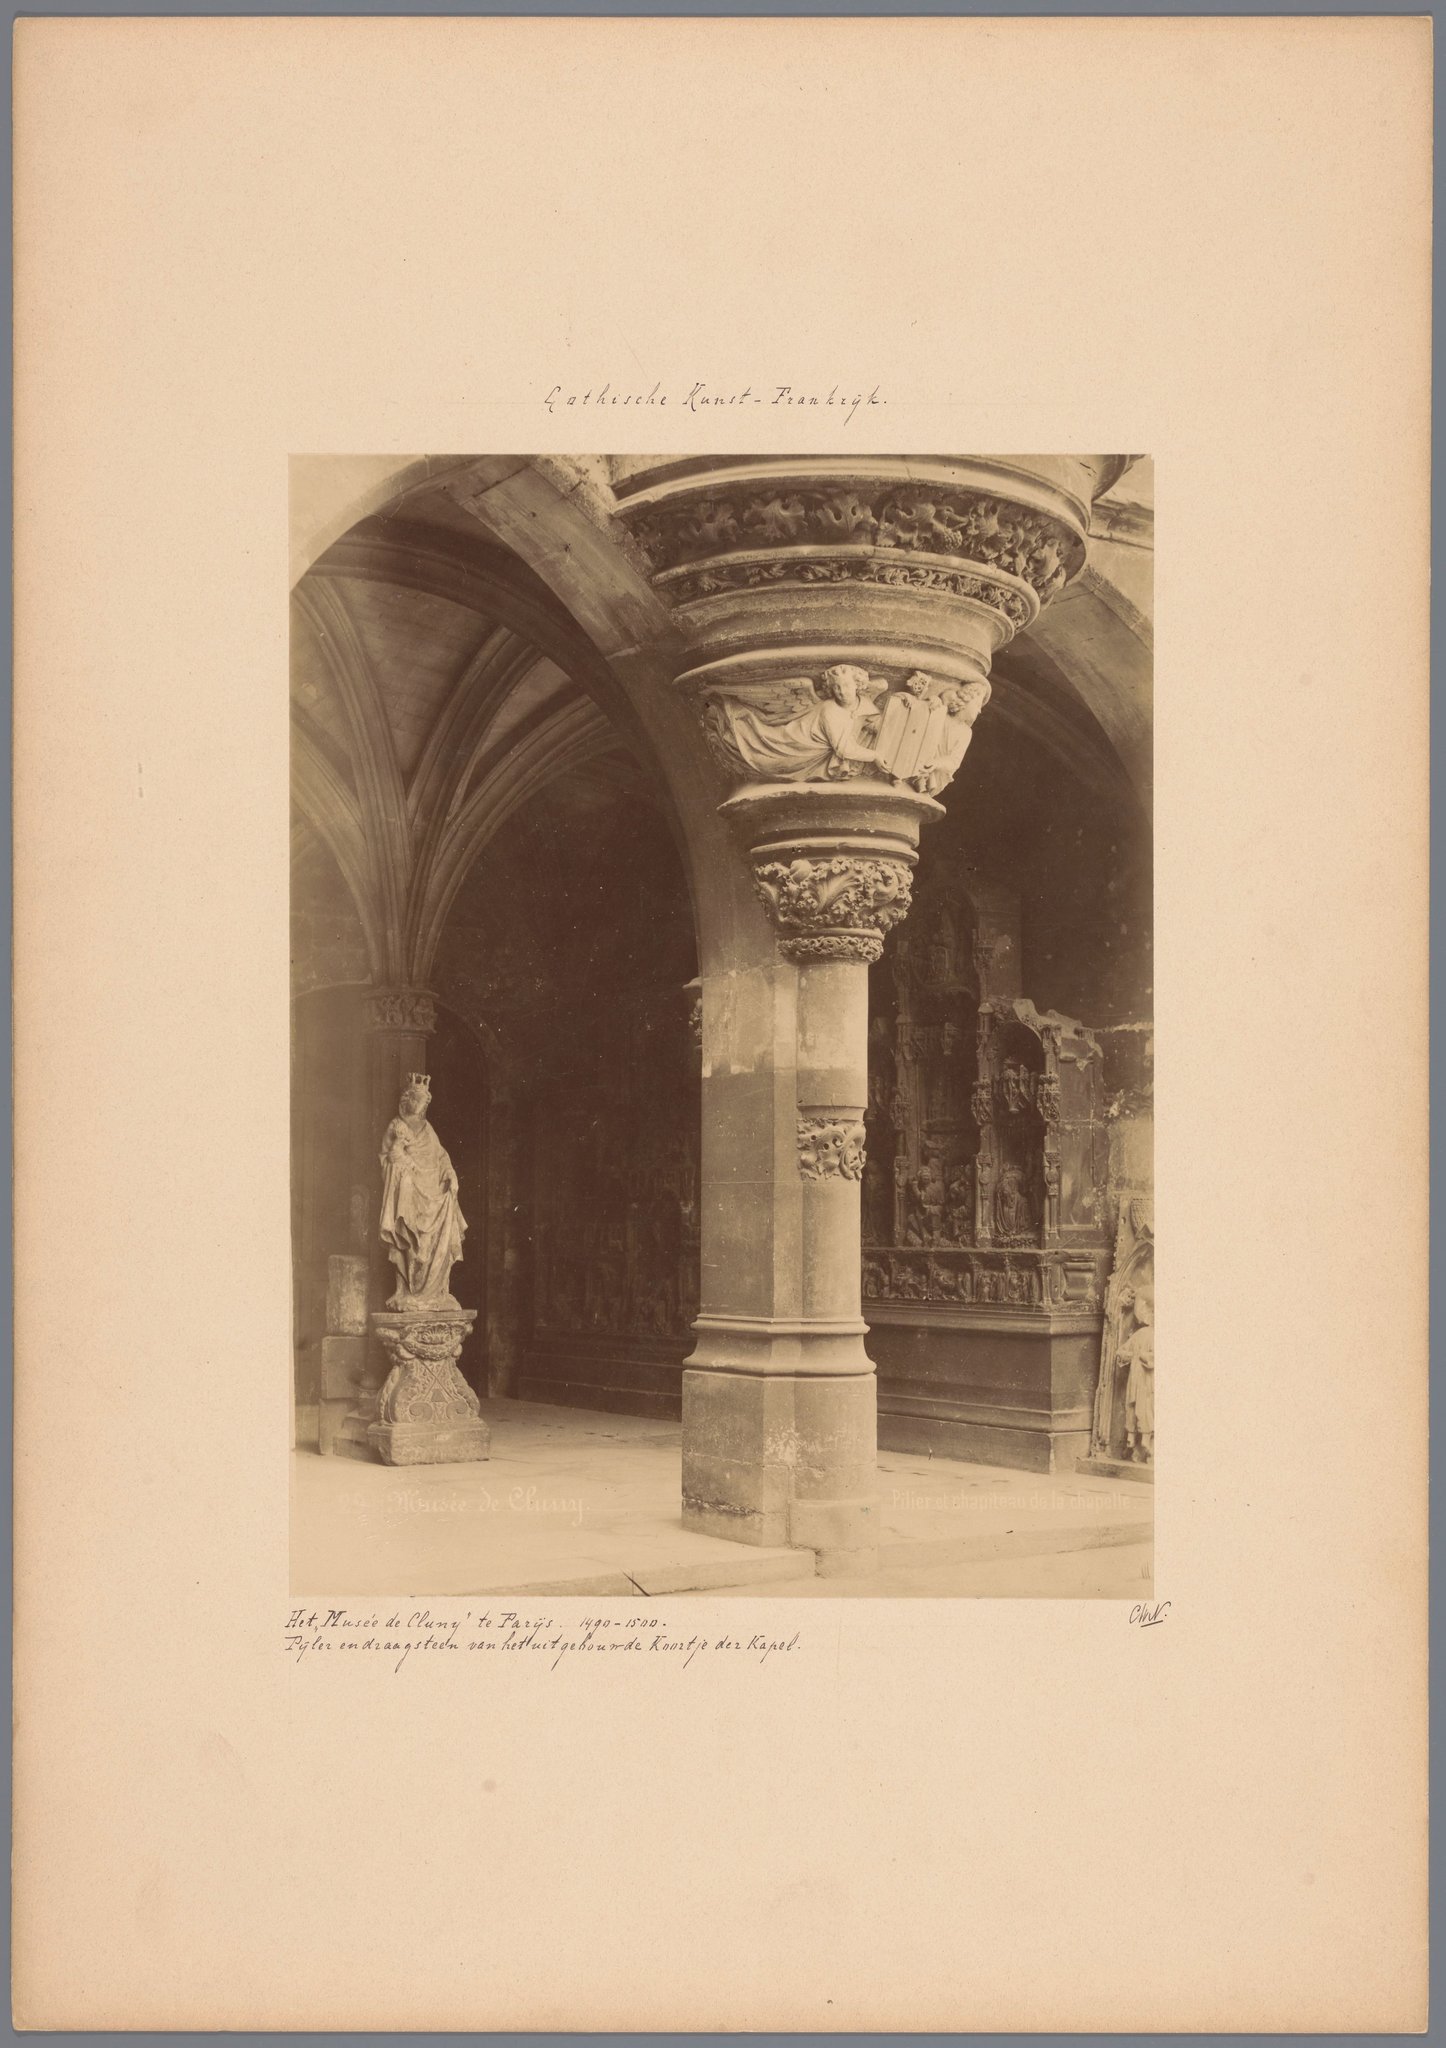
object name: photograph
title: Kapel van het Musée de Cluny (Musée national du Moyen Âge) te Parijs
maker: paul robert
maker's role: fotograaf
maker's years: 1865-1905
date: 1875-1900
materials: cardboard, photographic support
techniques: albumen print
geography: paris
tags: piece of sculpture, reproduction of a piece of sculpture, permanent exhibition, museum, parts of church interior: chapel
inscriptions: inscription: ‘CWN.’, inscription: ‘Gothische Kunst - Frankrijk.’, name: ‘PAUL ROBERT PARIS’, number: ‘29’, collector's mark: ‘INSTITUUT VOOR KUNST-NIJVERHEIDSONDERWIJS GABRIËL METSUSTRAAT No. 16 AMSTERDAM’, collector's mark: ‘KUNSTNIJVERHEIDSCHOOL QUELLINUS AMSTERDAM FRANS HALSSTRAAT 14.’